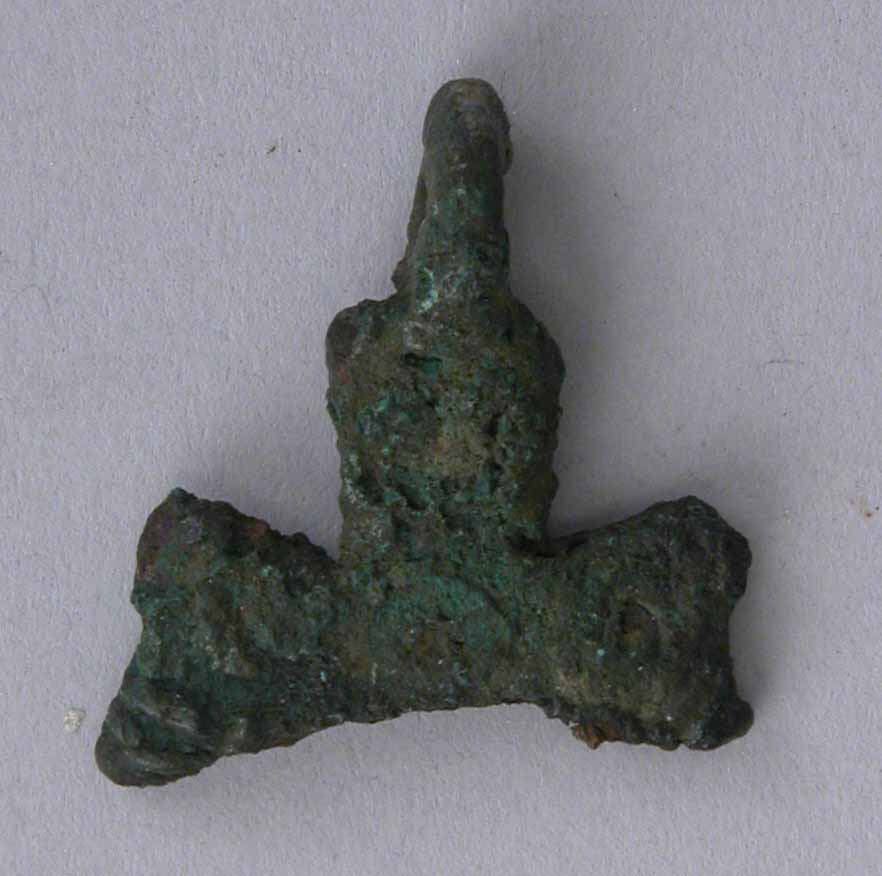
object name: cross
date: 201-1200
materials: bronze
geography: egypt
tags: cross